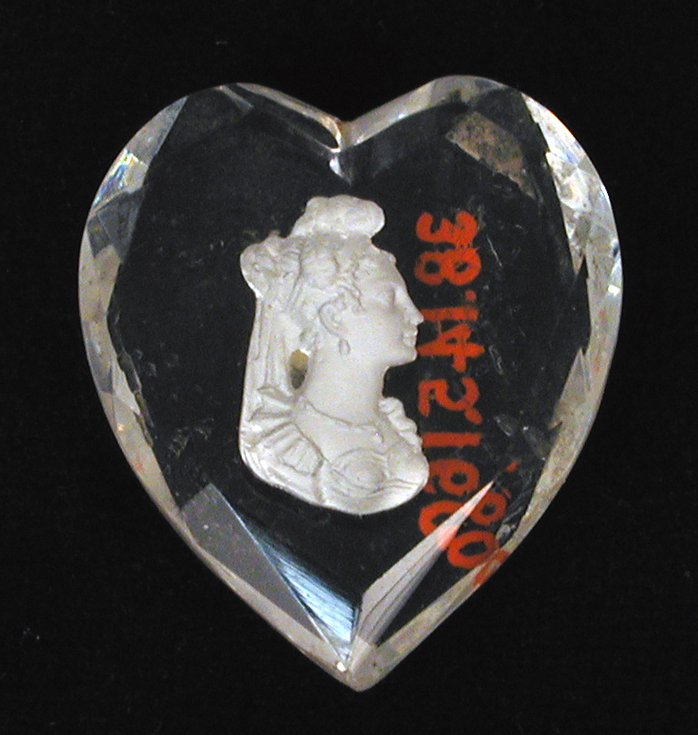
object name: medallion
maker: désprez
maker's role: maker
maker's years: 1773-1815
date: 1801-1900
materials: biscuit, glass, porcelain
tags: profiles,women